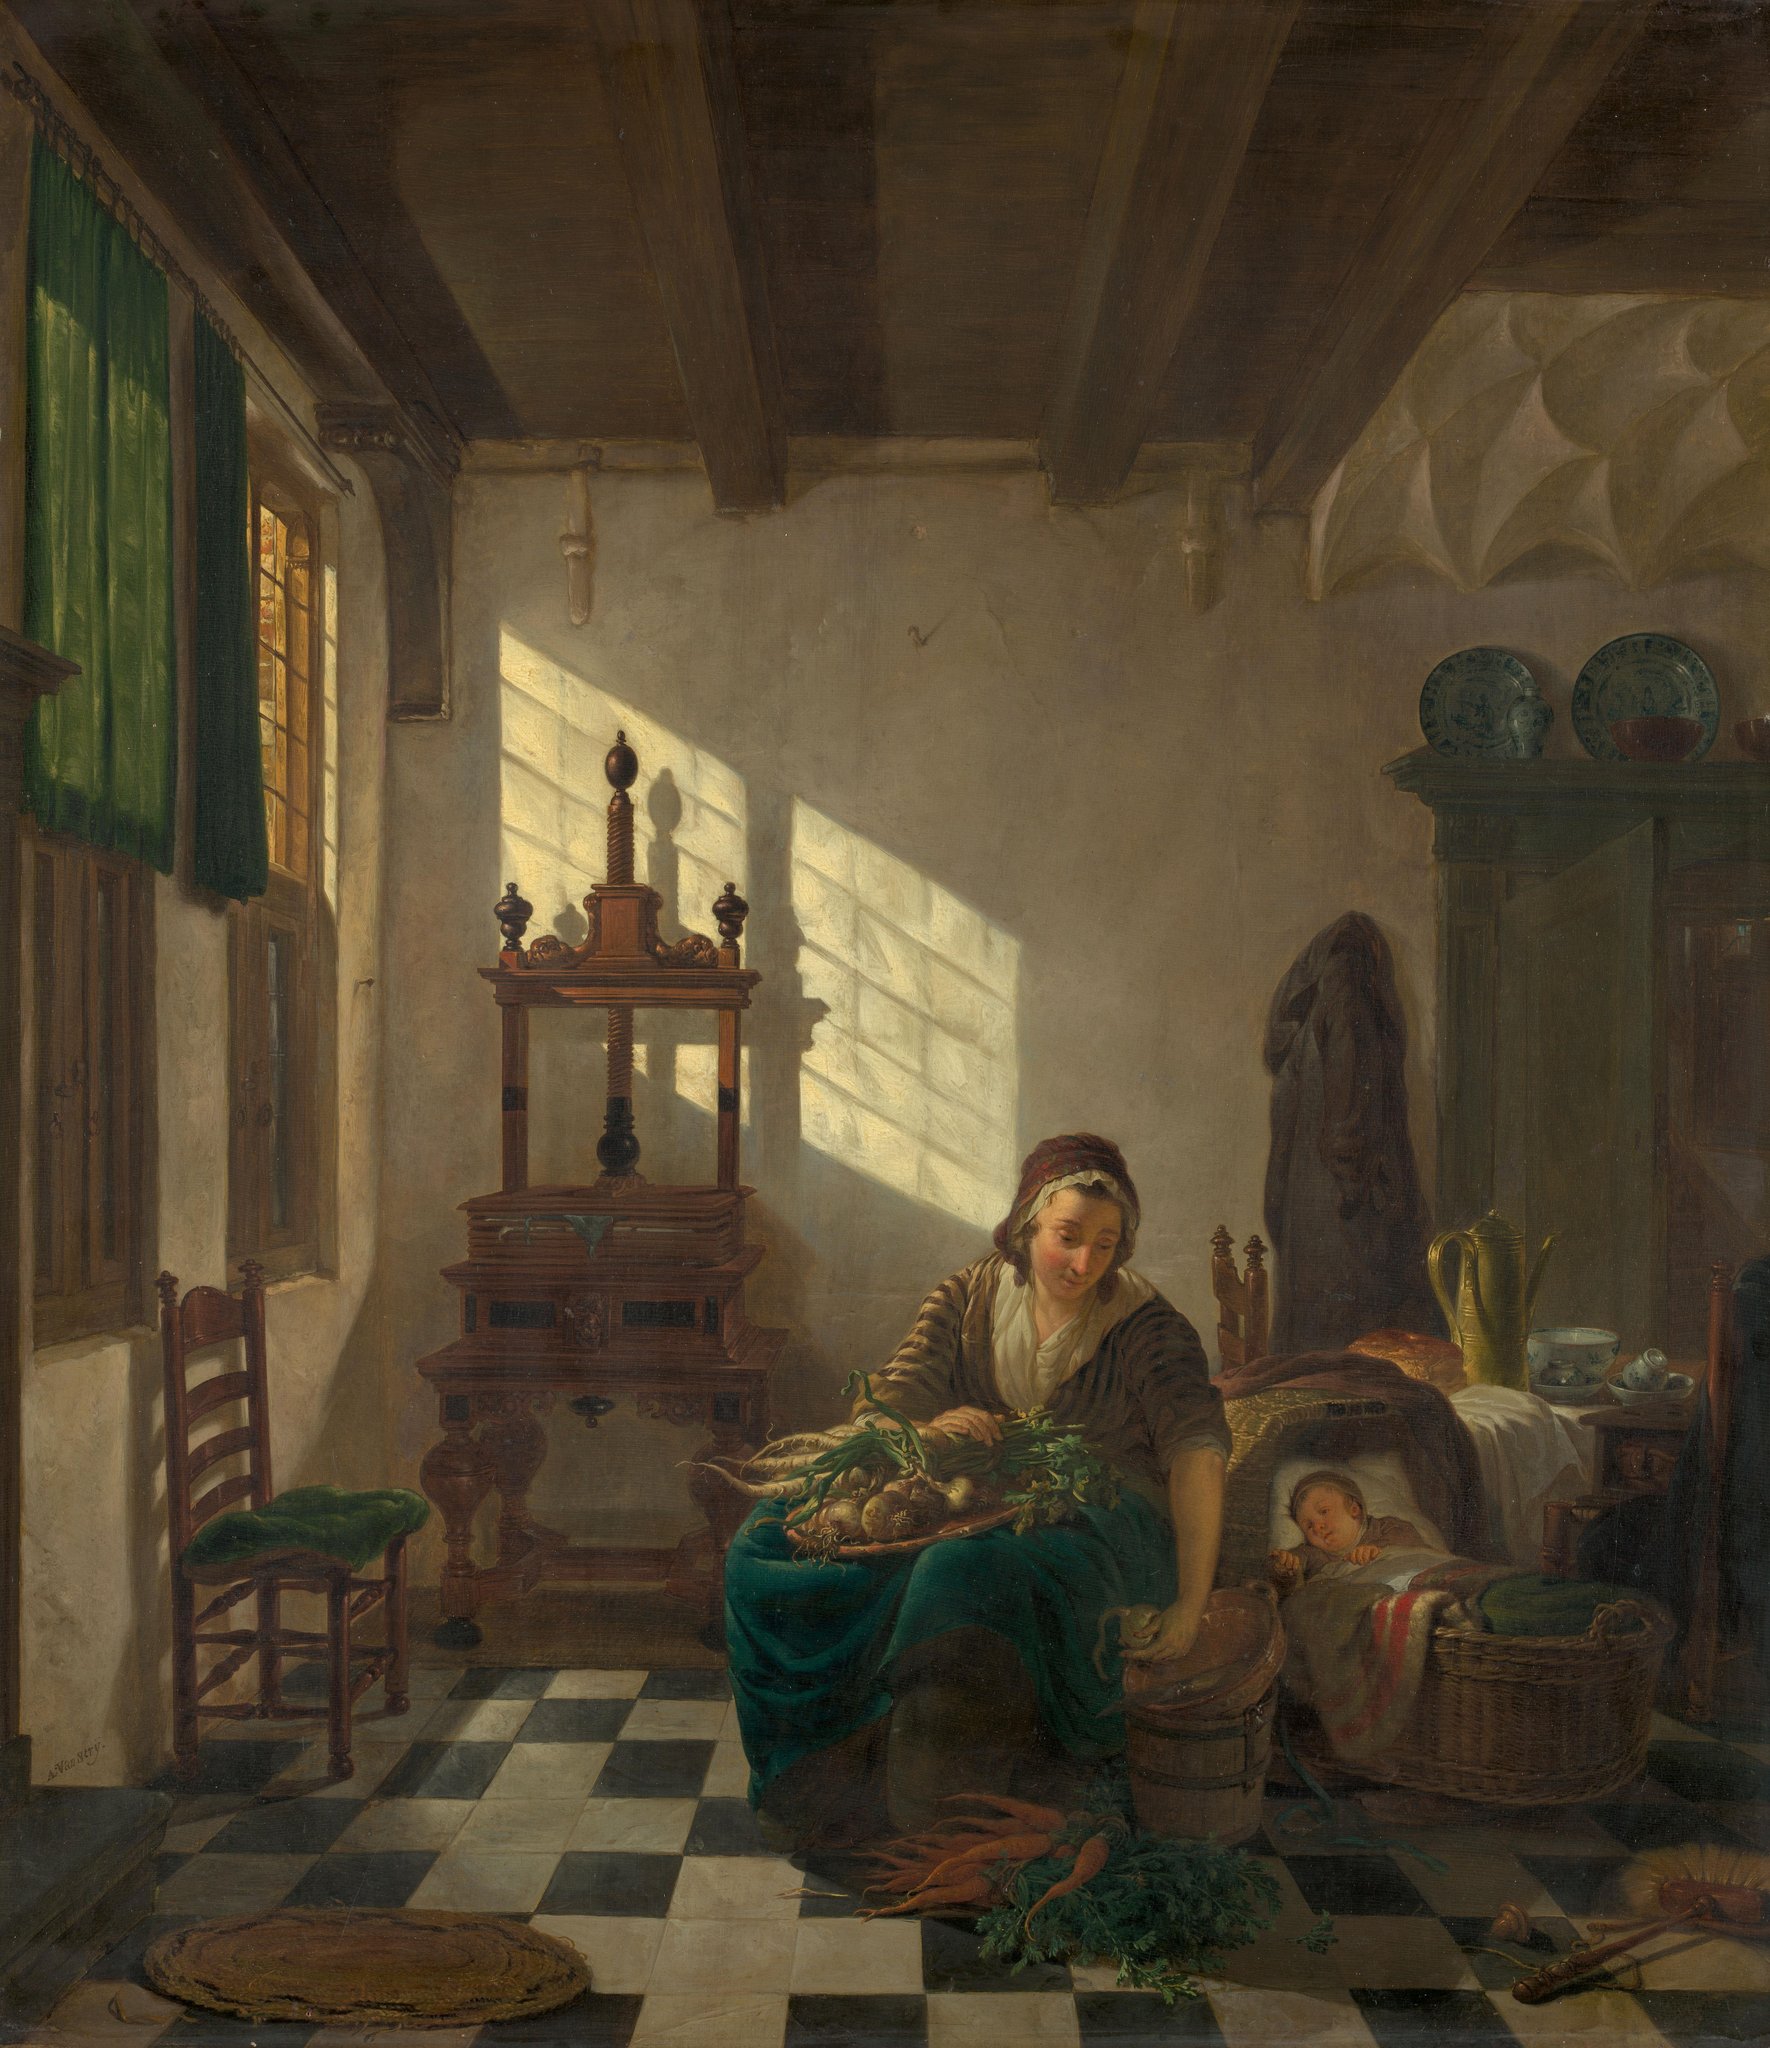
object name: painting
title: The Housewife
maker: abraham van strij (i)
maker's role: draughtsman, painter, print maker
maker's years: 1753-1826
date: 1800-1811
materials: oil, panel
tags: cradle, crib, mother and baby or young child, cleaning vegetables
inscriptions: signature: ‘A. van Strij’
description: De huisvrouw. Interieur met een moeder zittend bij de wieg van haar kind. De vrouw heeft op schoot een mand met groente. Links in de doek van de kamer staat een pers.